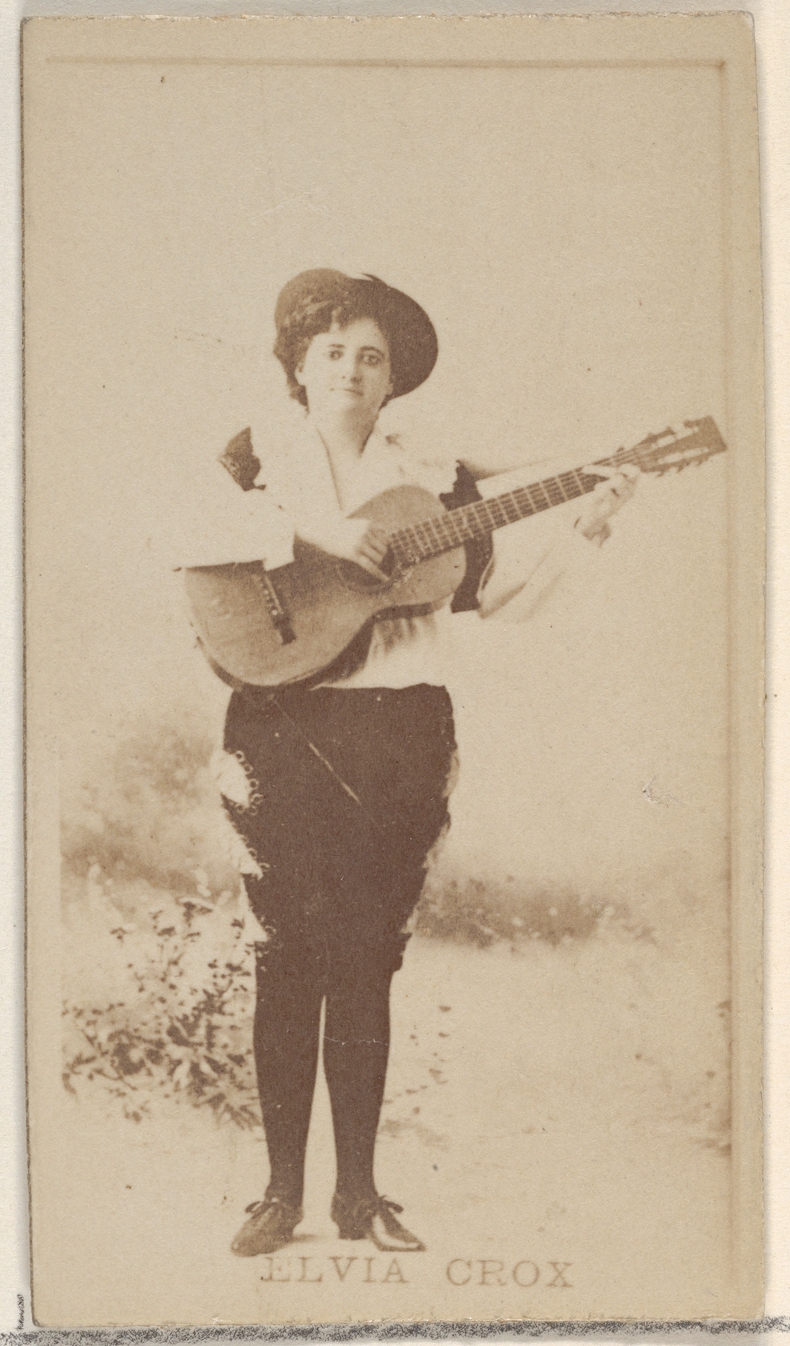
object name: photograph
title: Elvia Crox, from the Actors and Actresses series (N45, Type 8) for Virginia Brights Cigarettes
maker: allen & ginter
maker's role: publisher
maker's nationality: american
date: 1888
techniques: albumen silver print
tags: portraits,women,guitars,actresses